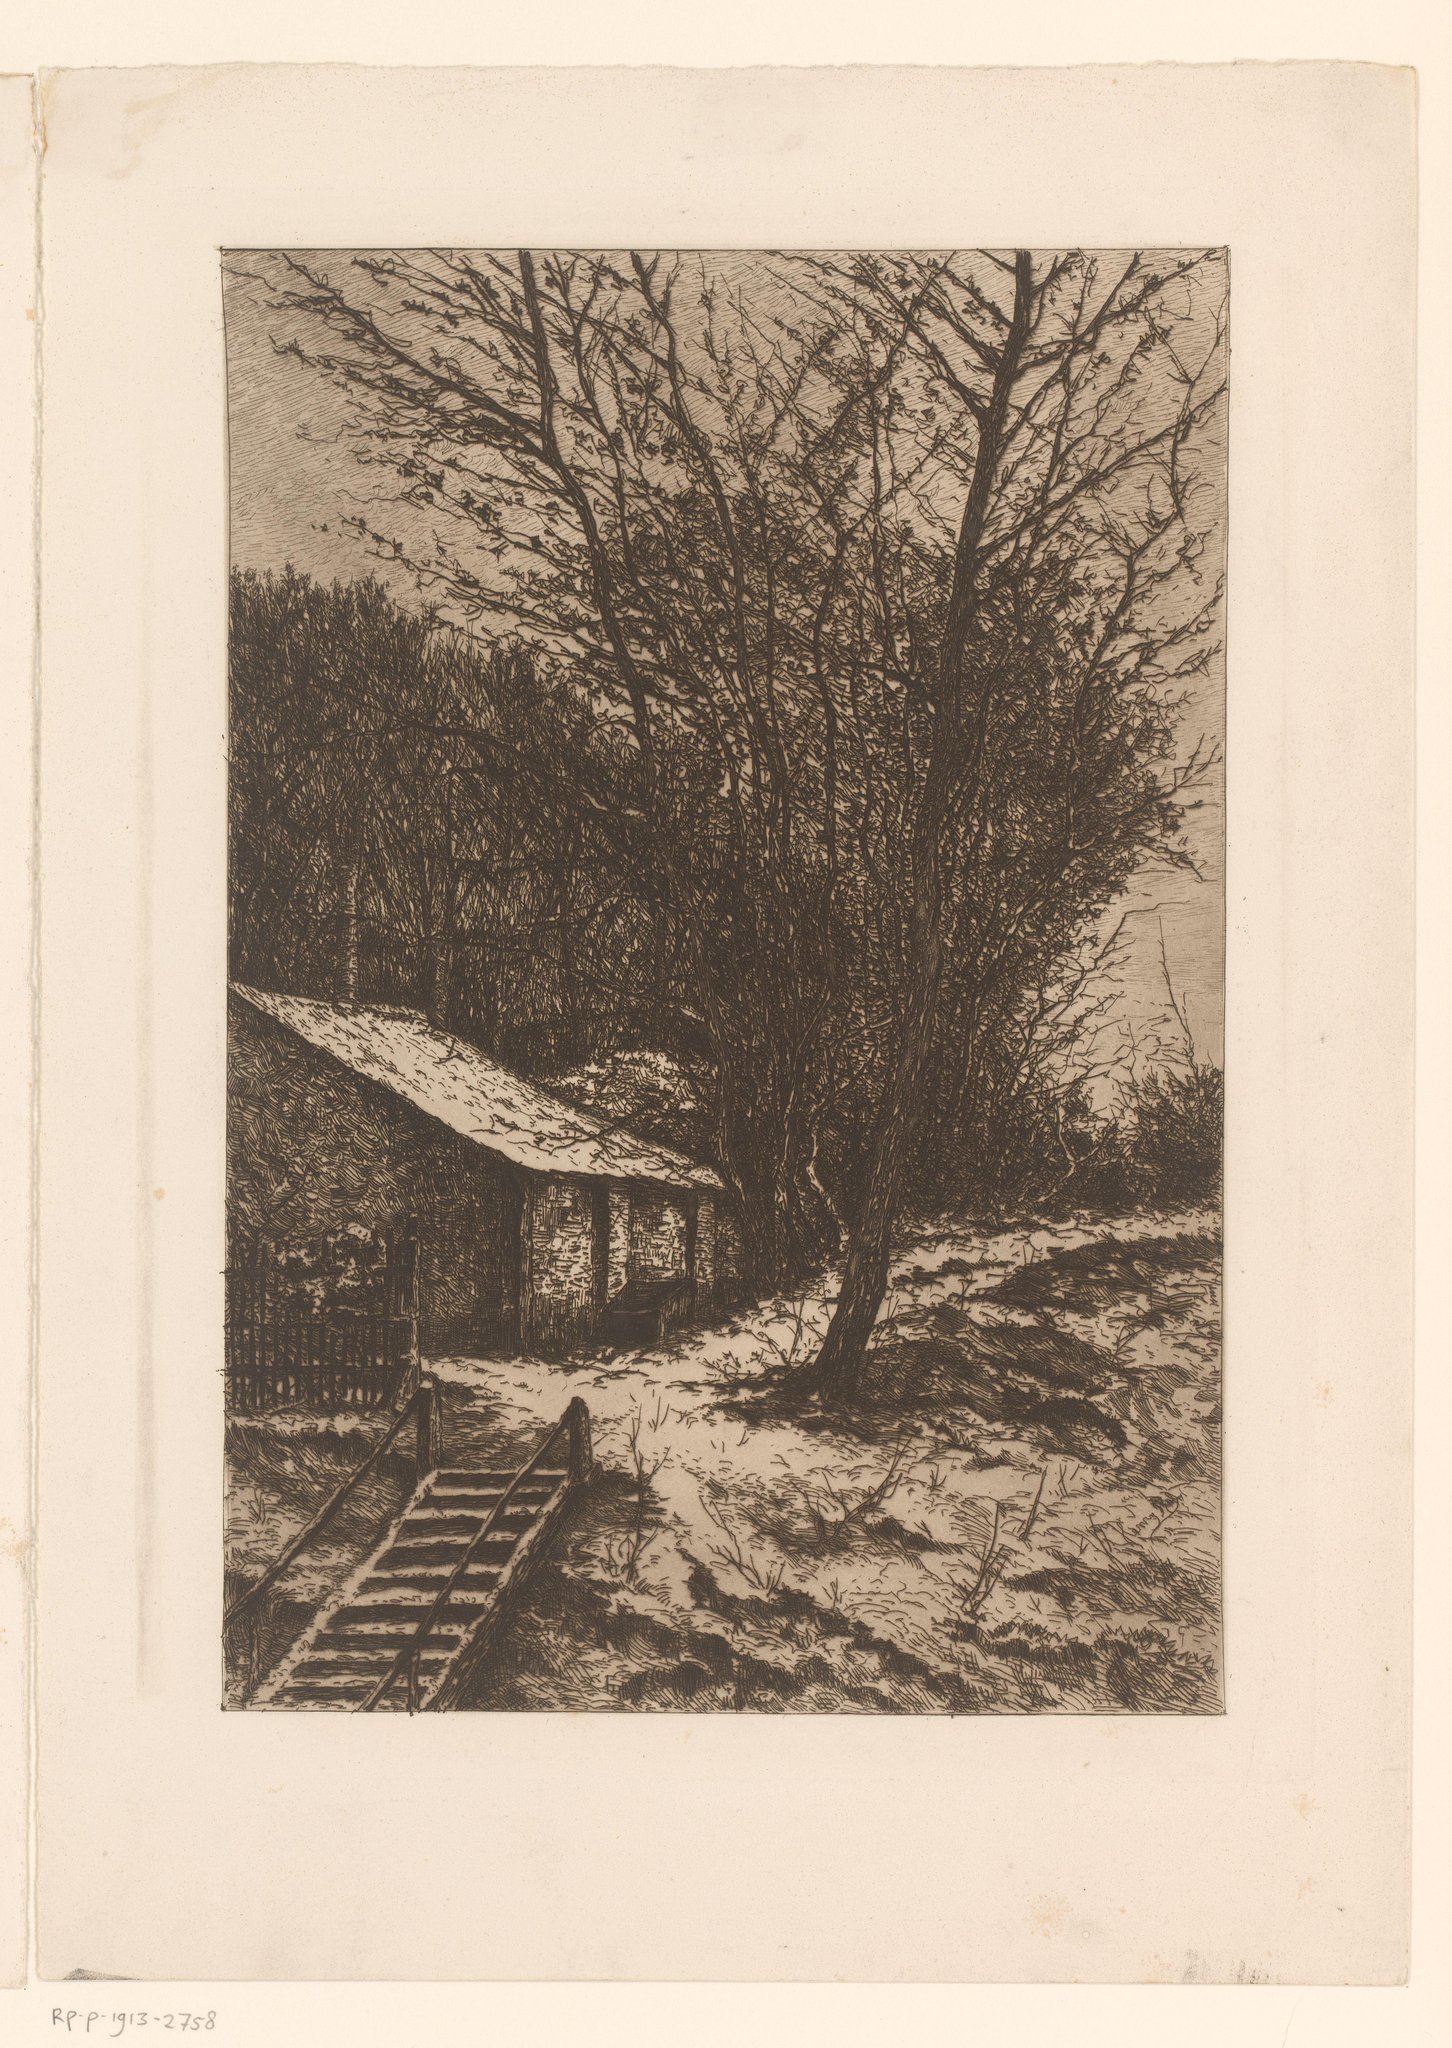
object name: print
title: Winterlandschap met boerderij bij een trap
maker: henri rul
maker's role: print maker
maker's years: 1862-1942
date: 1872-1913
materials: paper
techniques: etching, intaglio, retroussage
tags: flight of steps, winter landscape; landscape symbolizing winter (the four seasons of the year), farm or solitary house in landscape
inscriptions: collector's mark: Lugt 2228